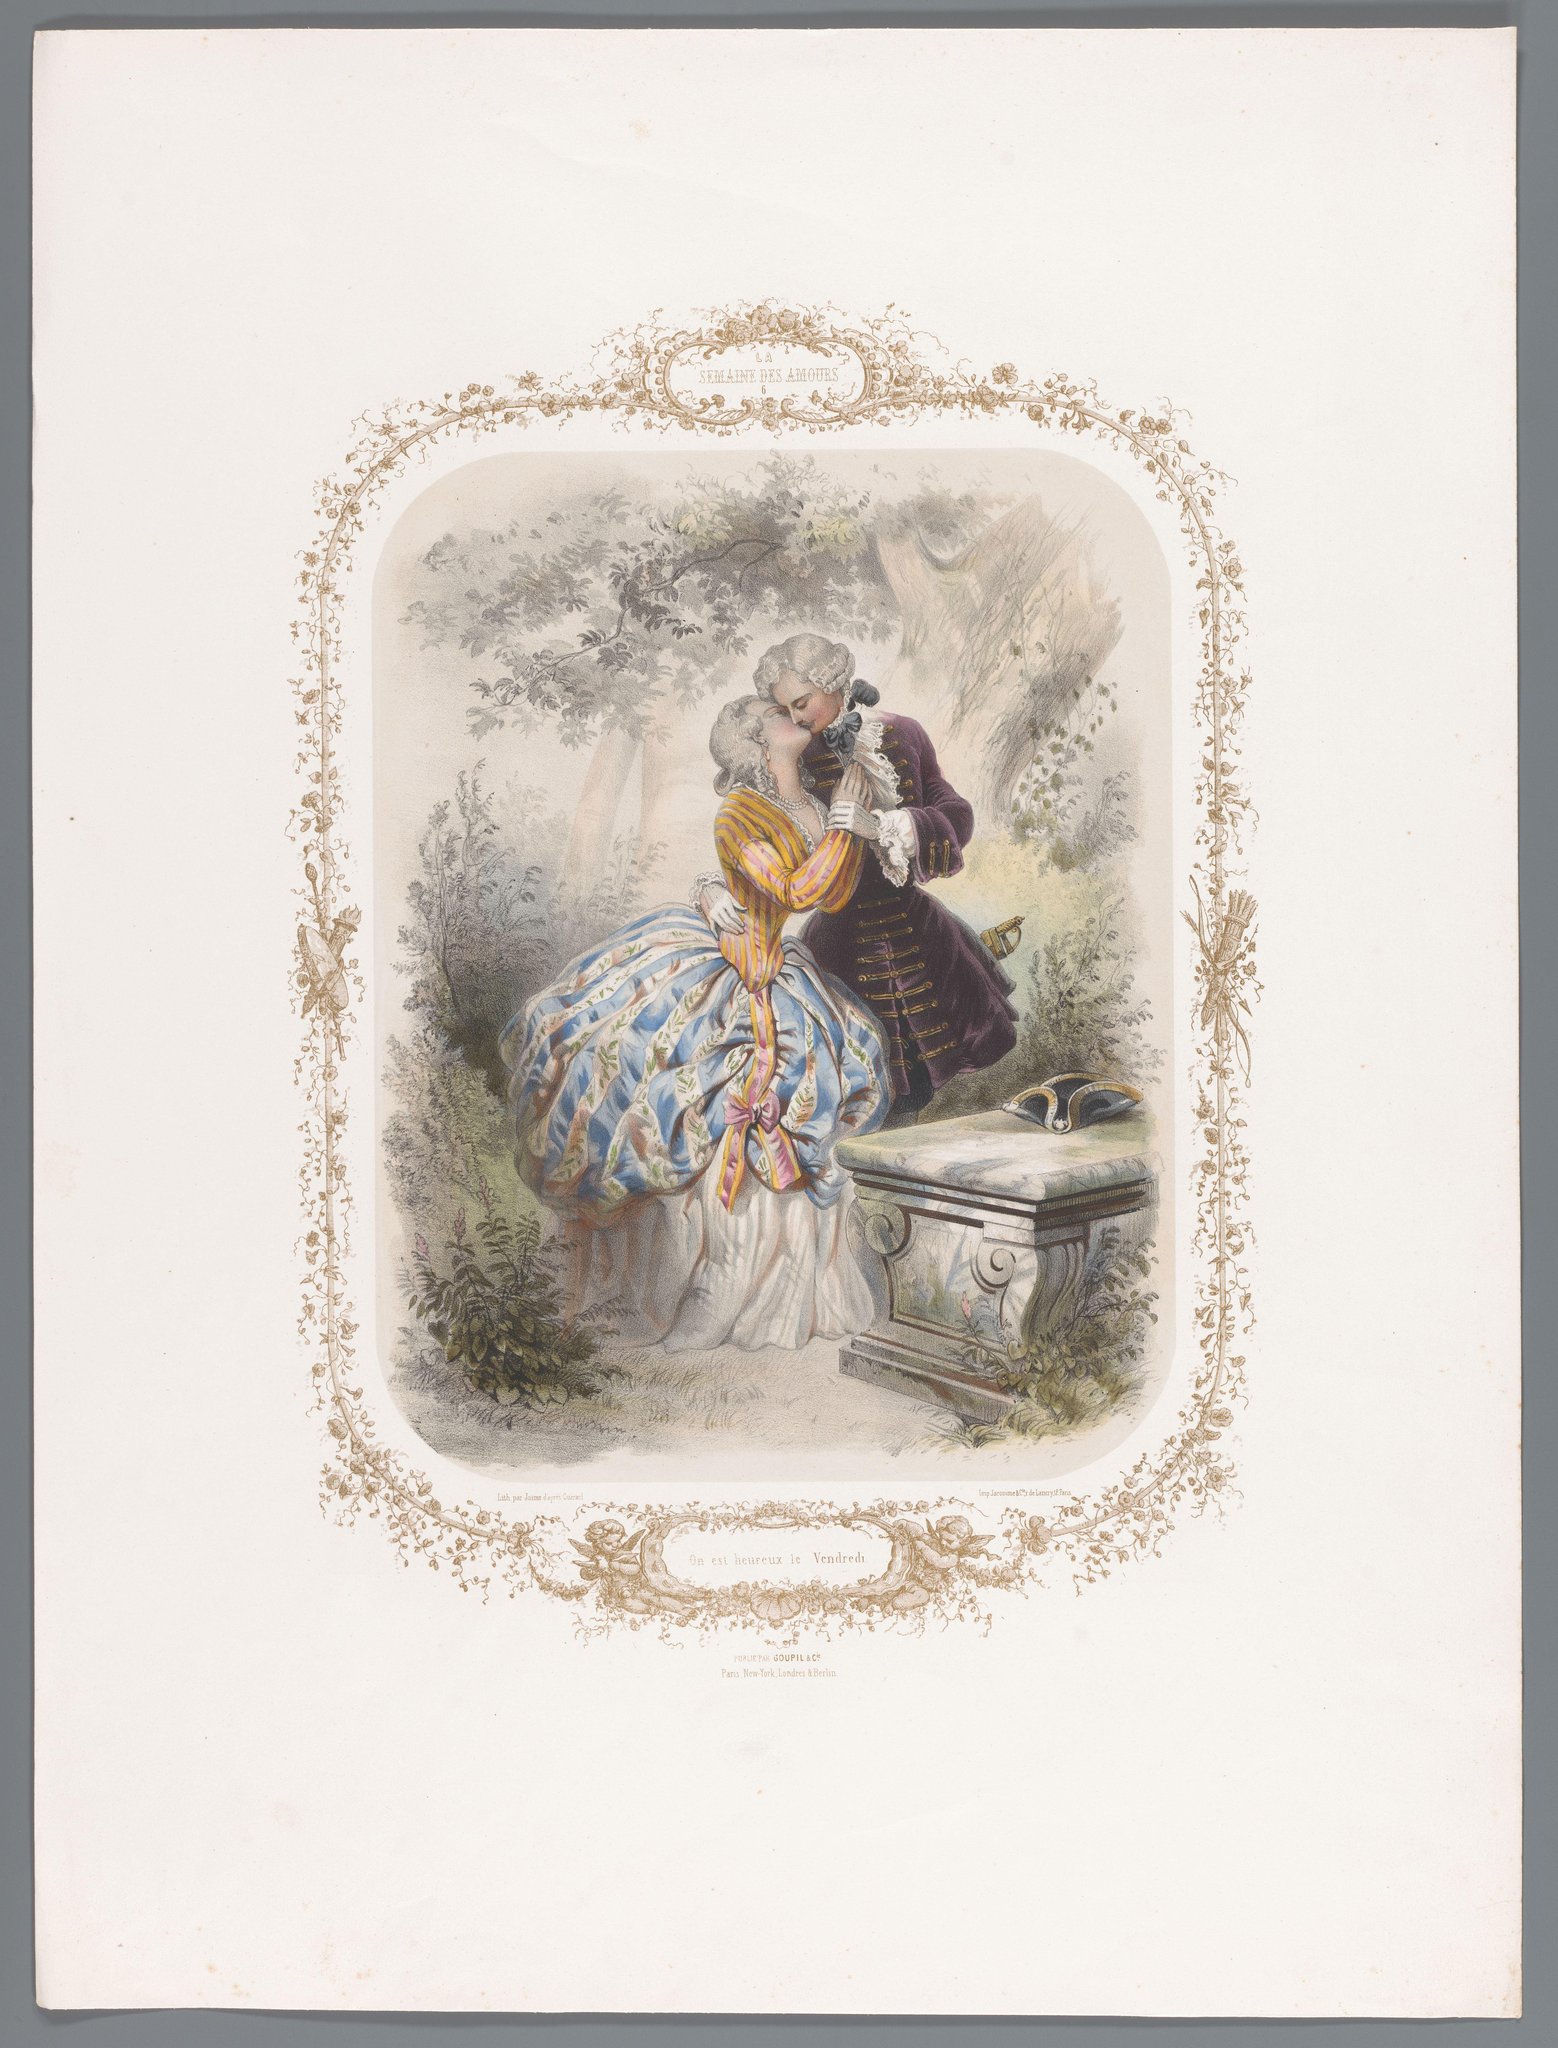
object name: print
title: Week van de liefde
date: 1852-1857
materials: paper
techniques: hand coloring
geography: paris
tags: dandy, beau, (lovers) kissing each other, fashionable woman, 'belle'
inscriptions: check stamp: Lugt 1090, collector's mark: Lugt 2233